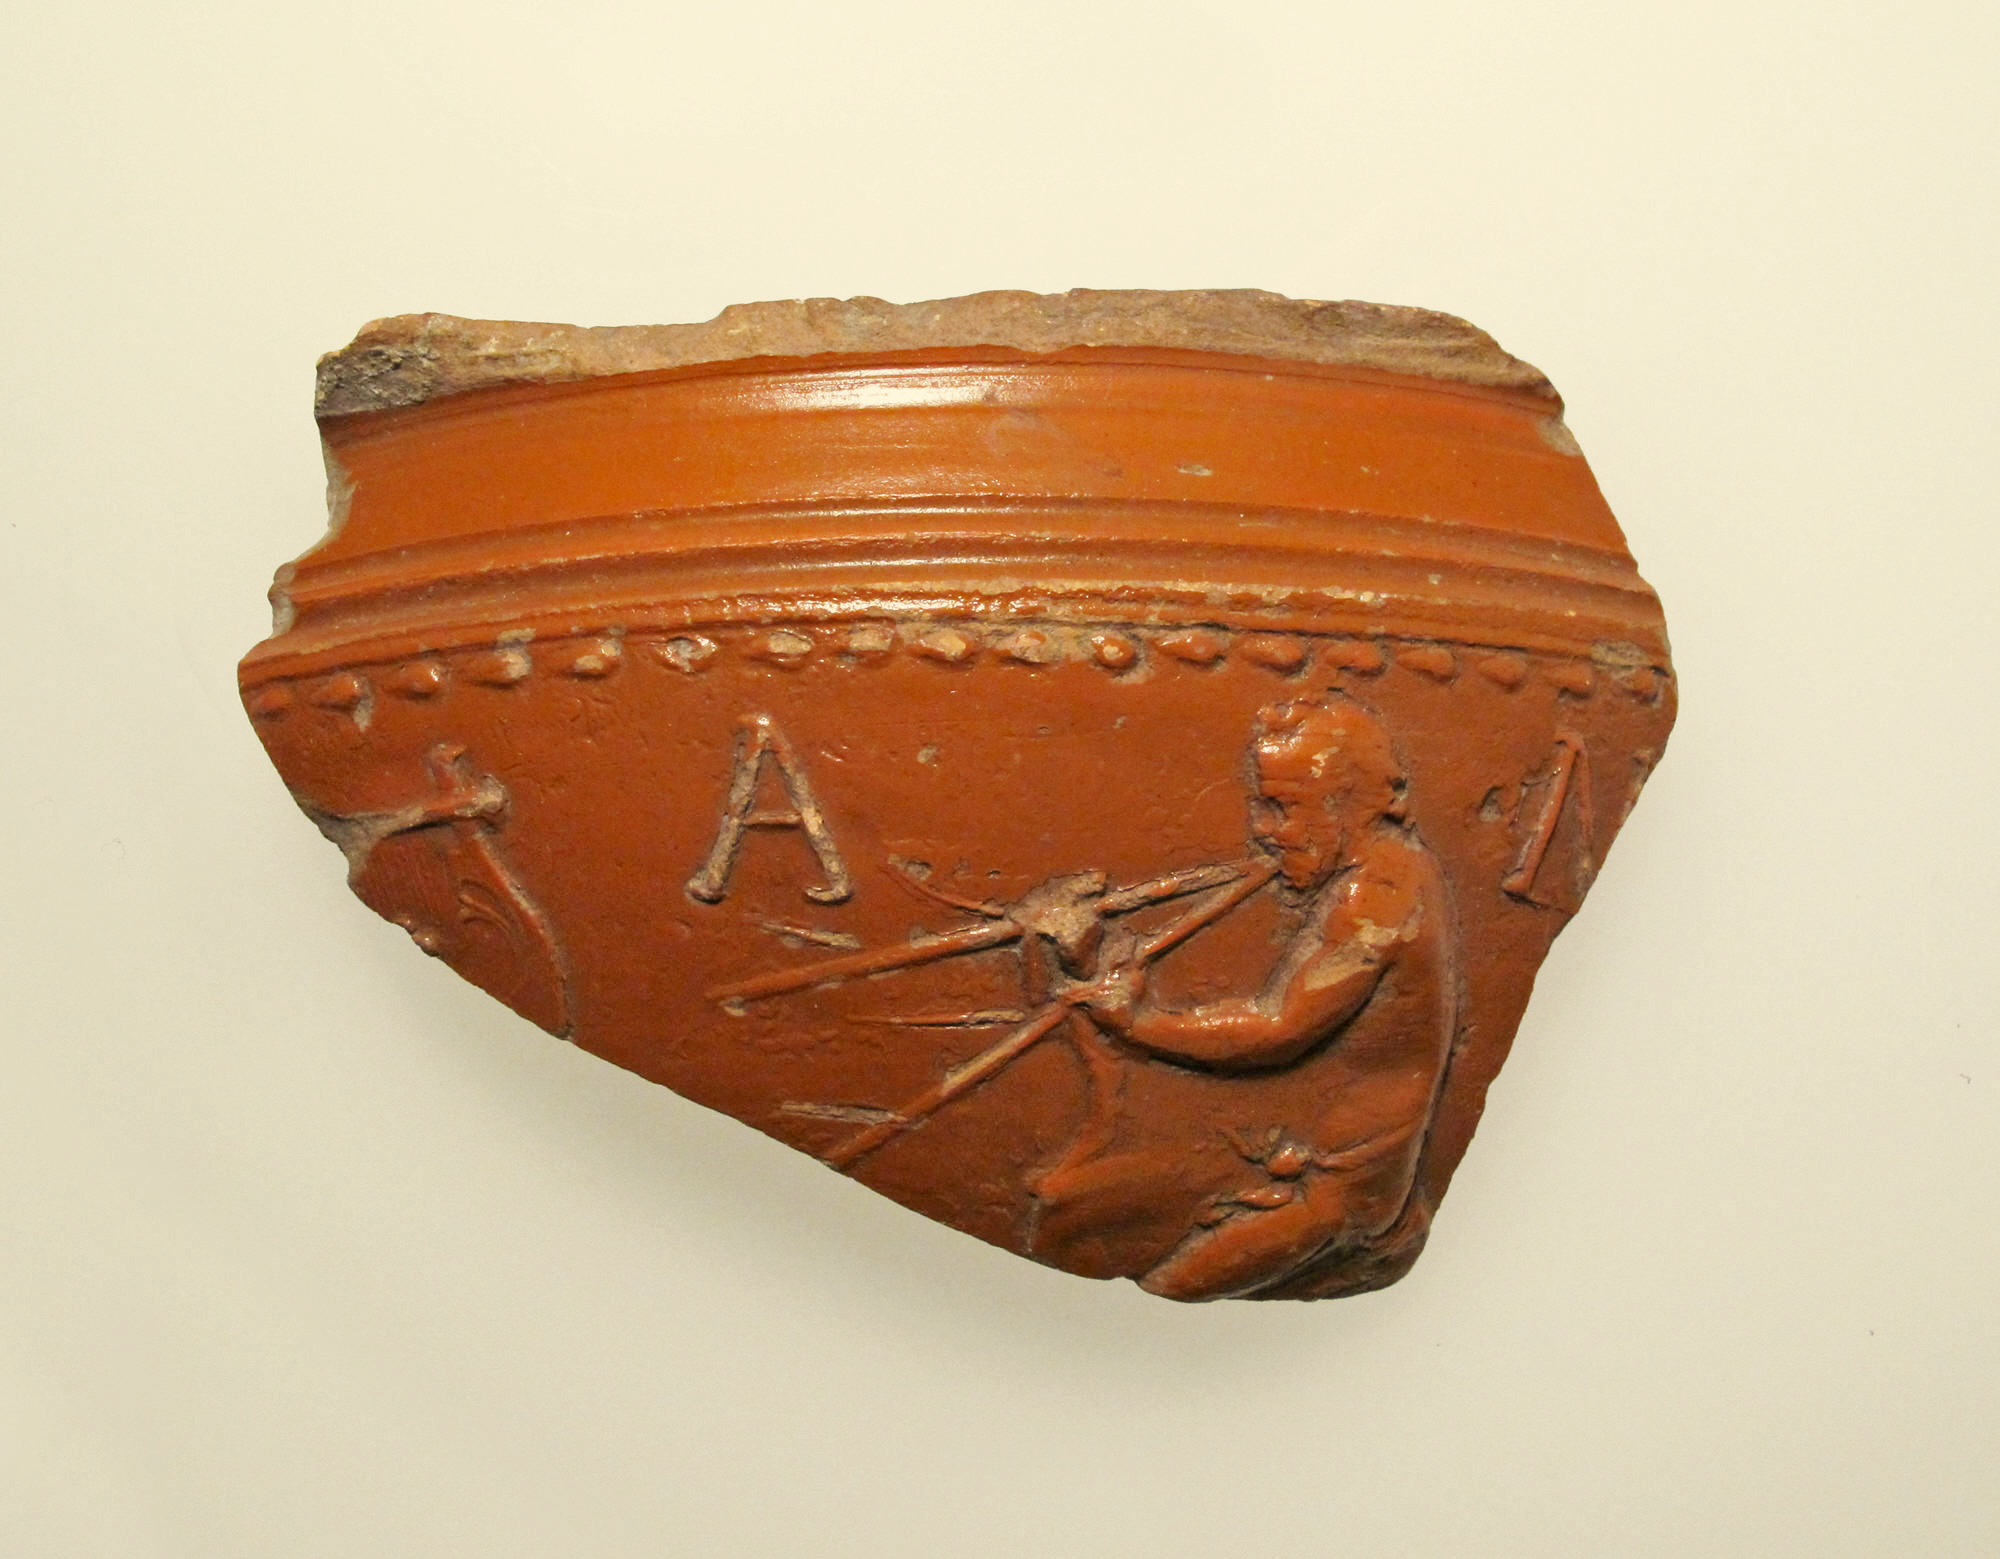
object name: vase fragment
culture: roman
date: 100 BCE-100 CE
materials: terracotta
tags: flutes,satyrs